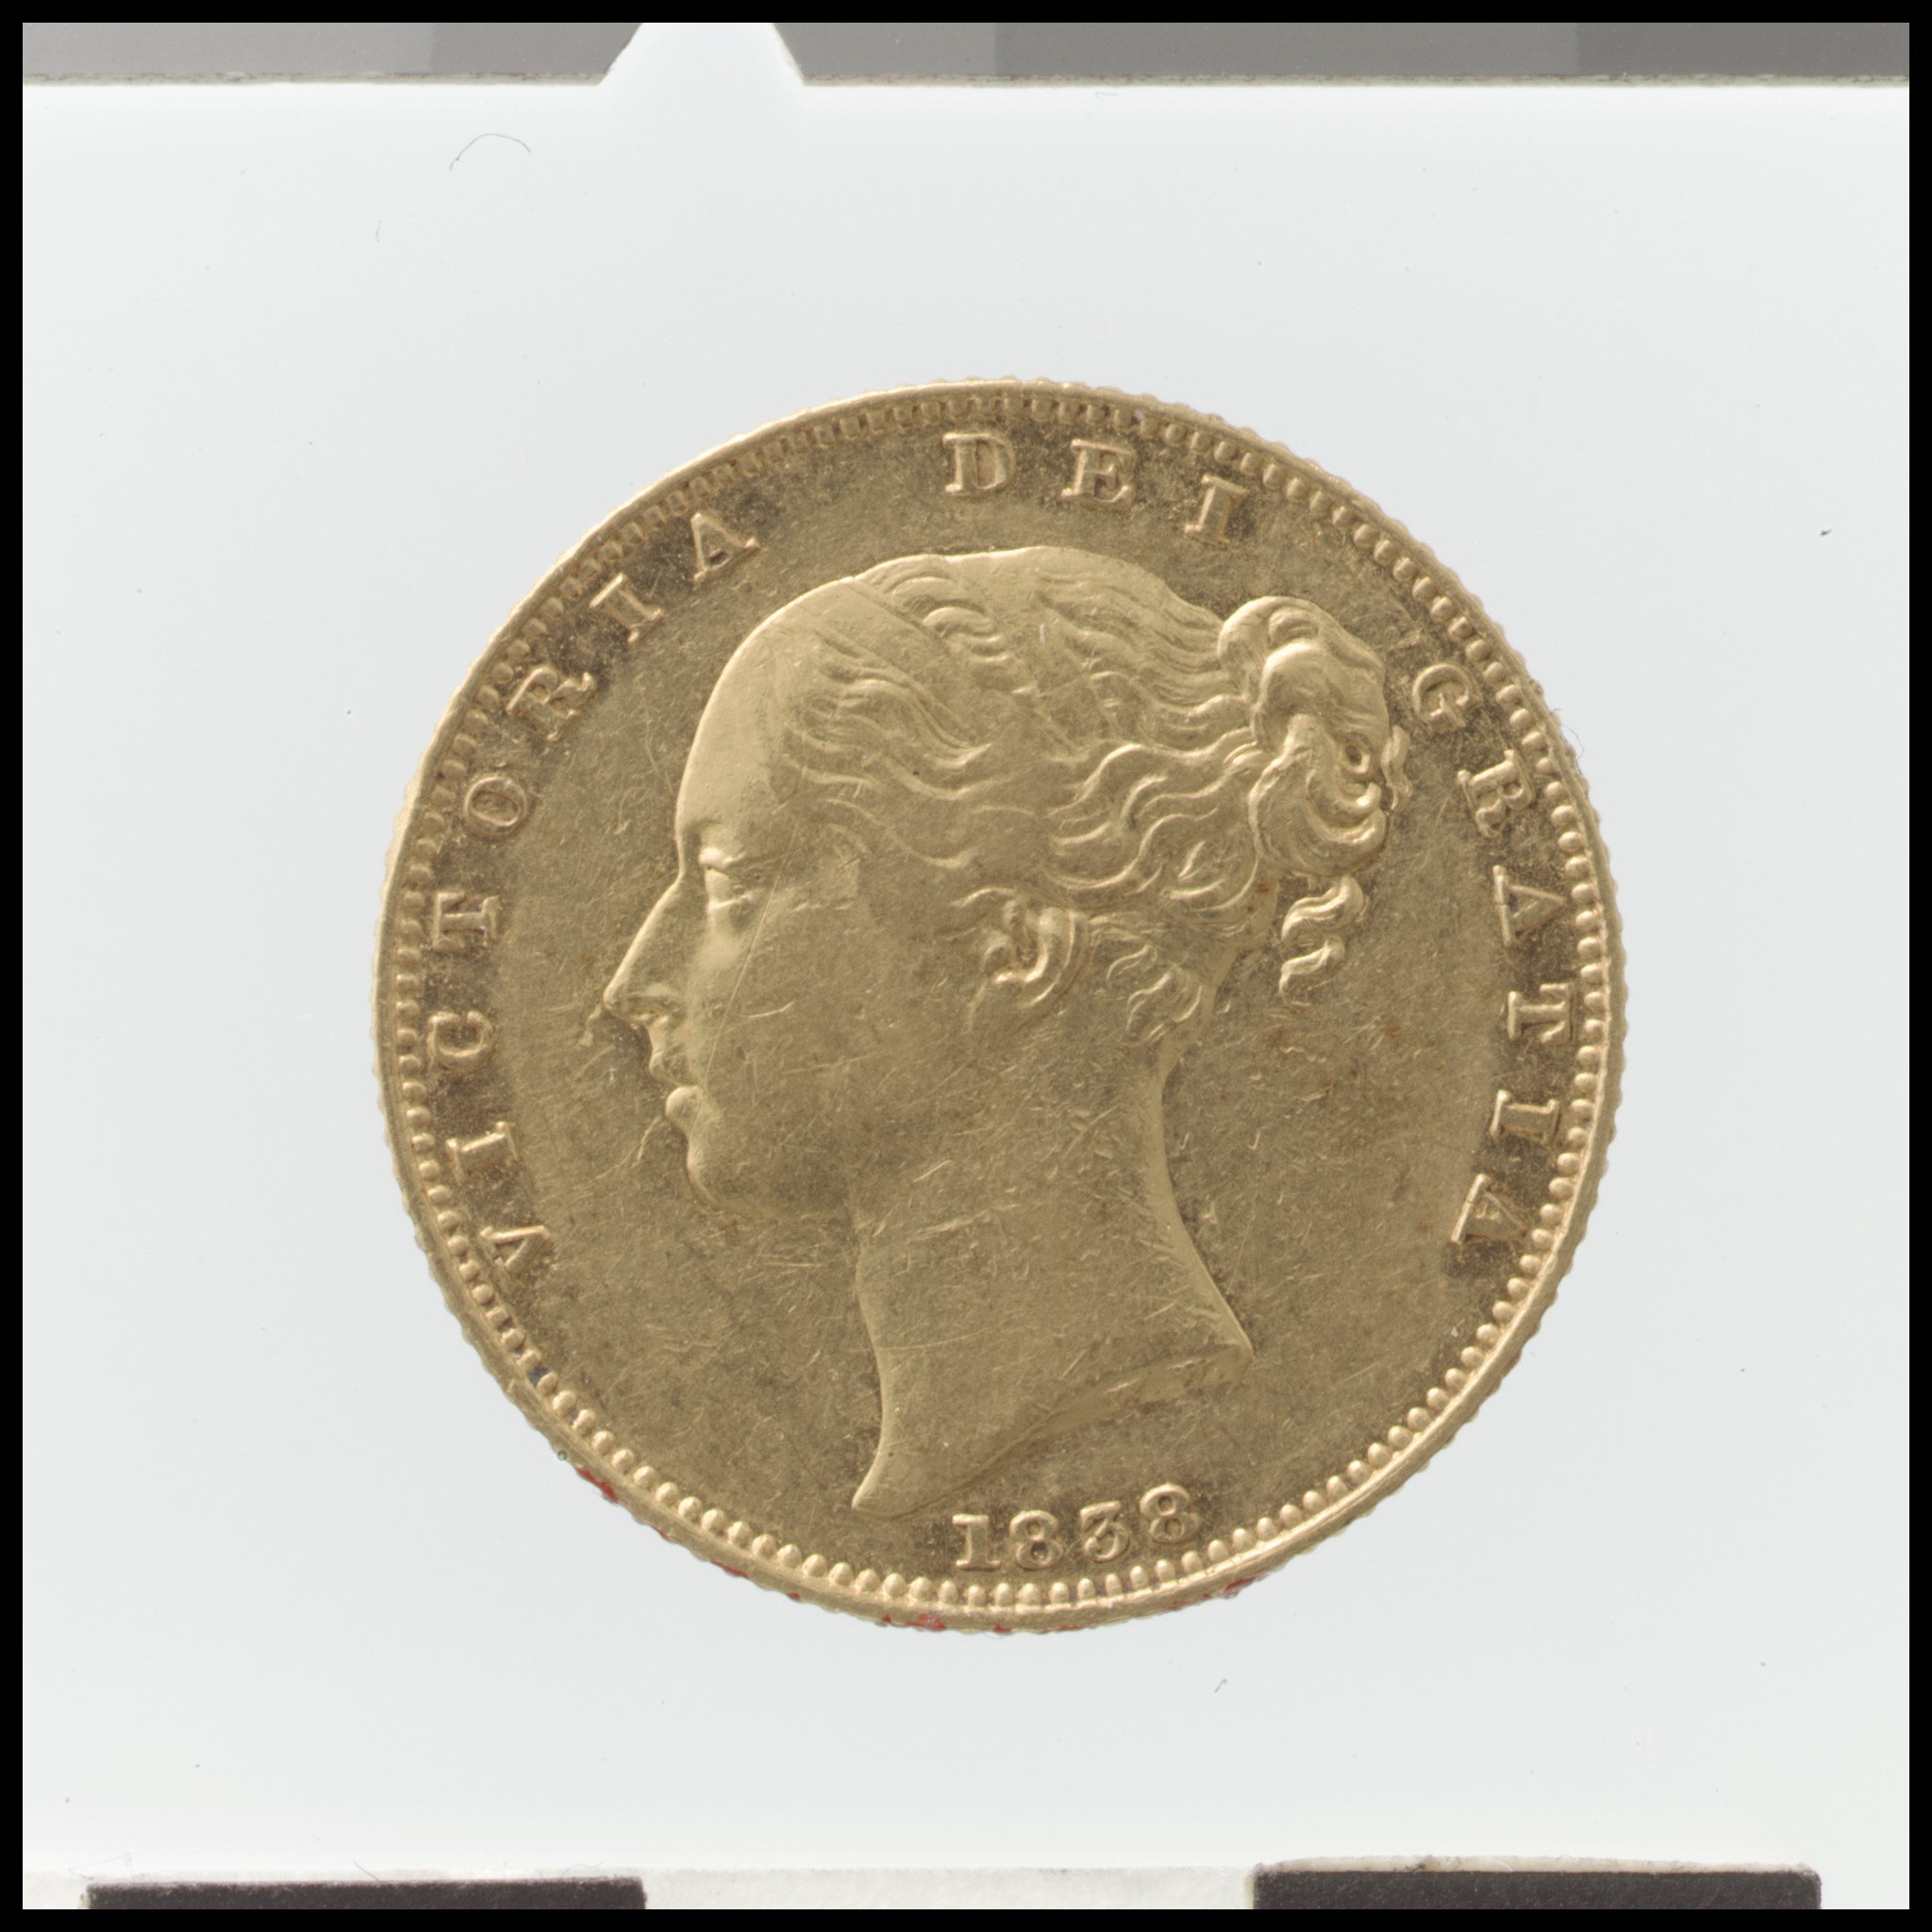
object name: sovereign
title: Victoria sovereign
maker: william wyon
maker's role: artist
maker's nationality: british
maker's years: 1795-1851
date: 1838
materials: gold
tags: profiles,women,coat of arms